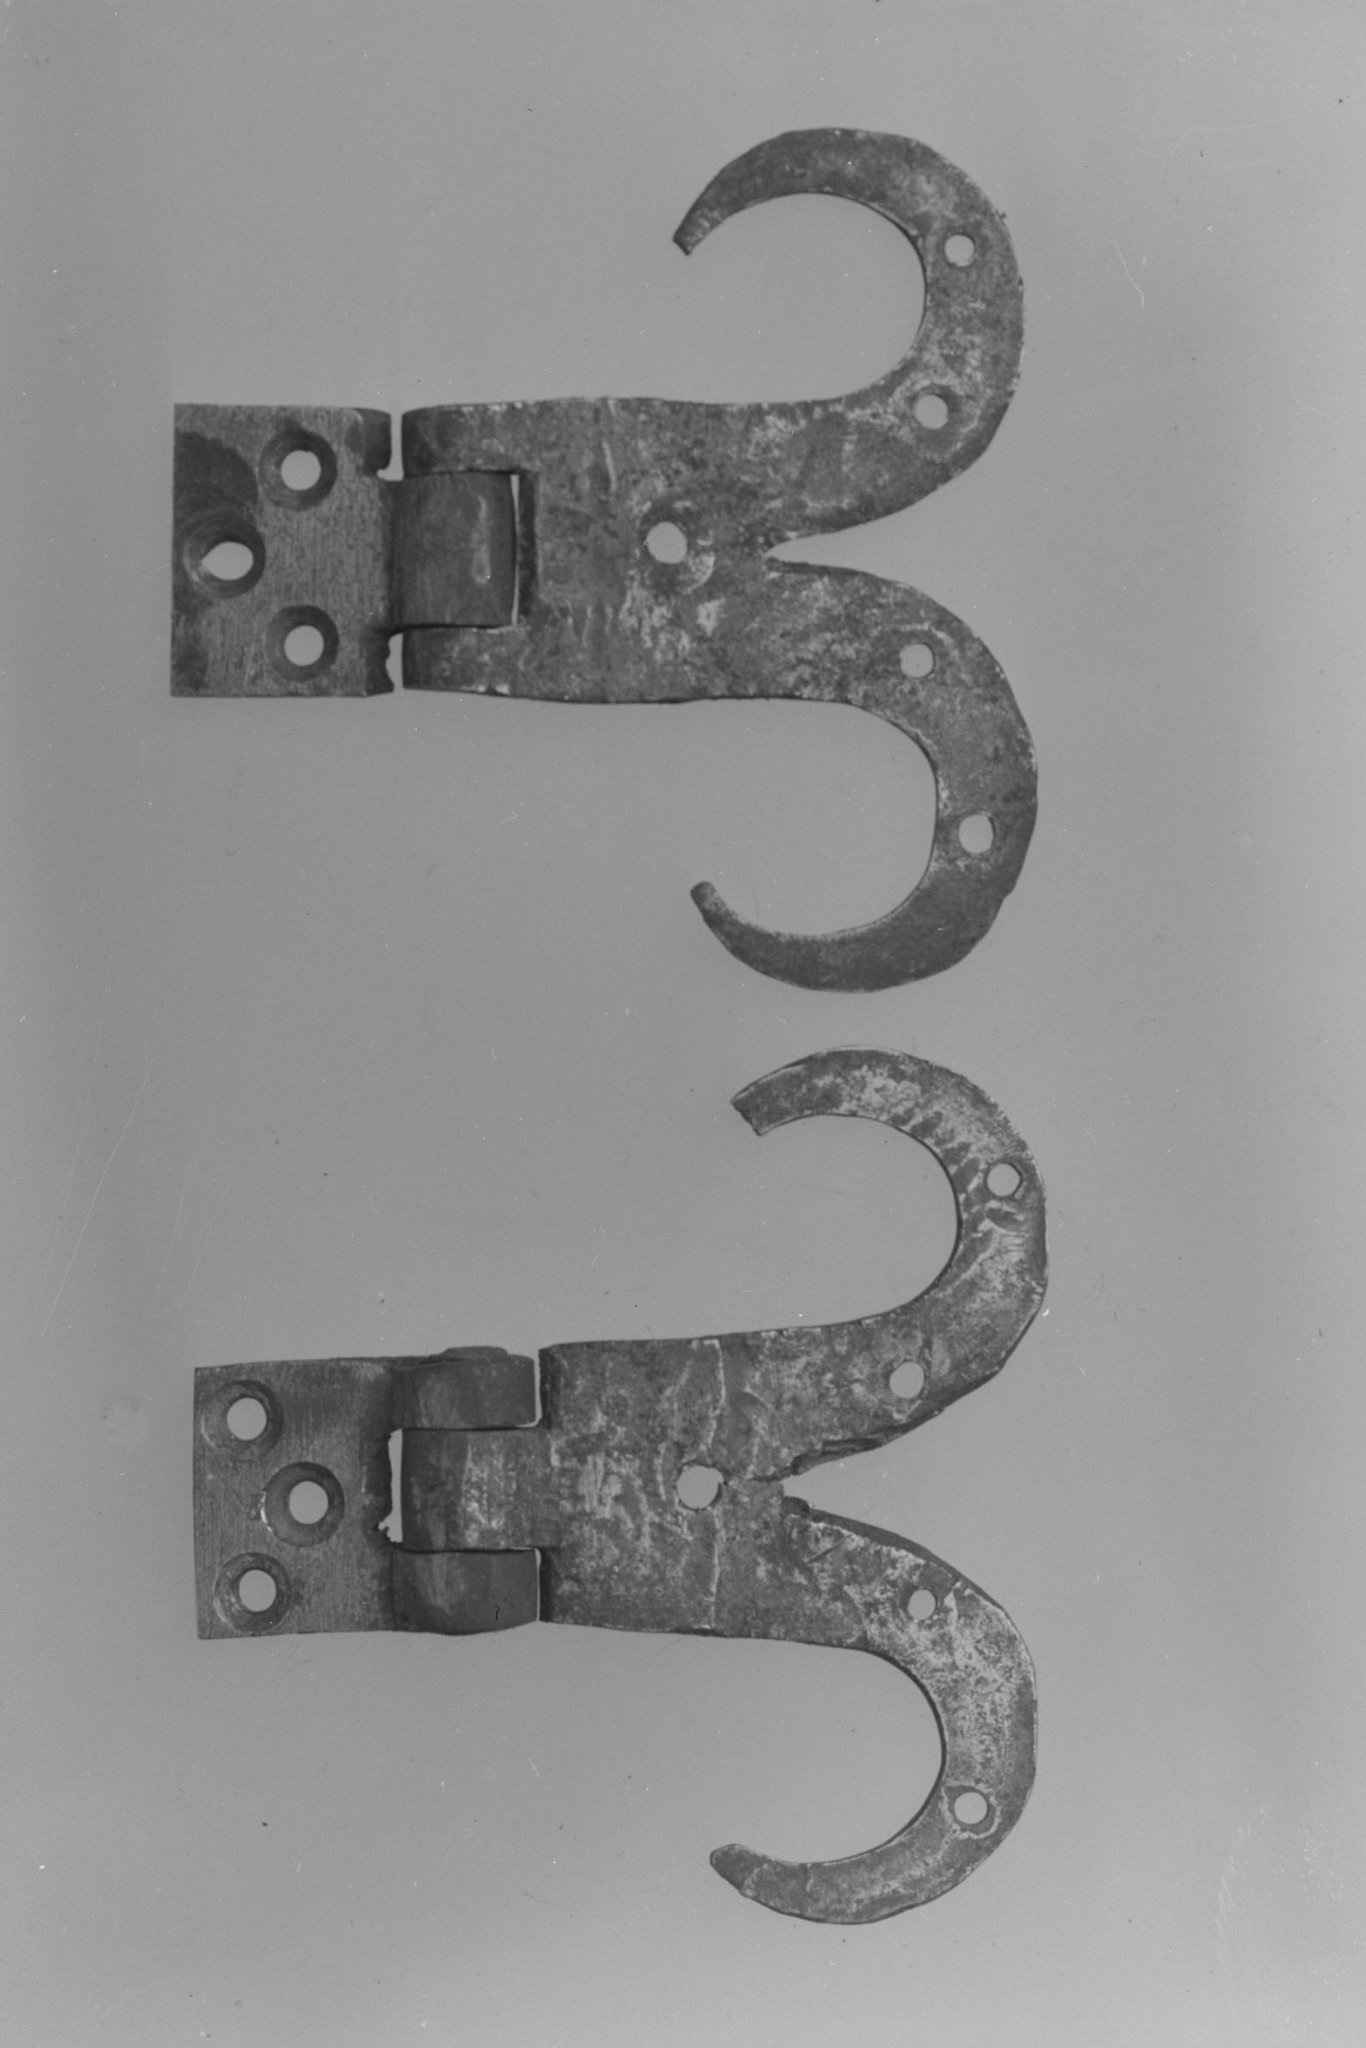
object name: hinge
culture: american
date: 1700-1800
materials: iron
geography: united states